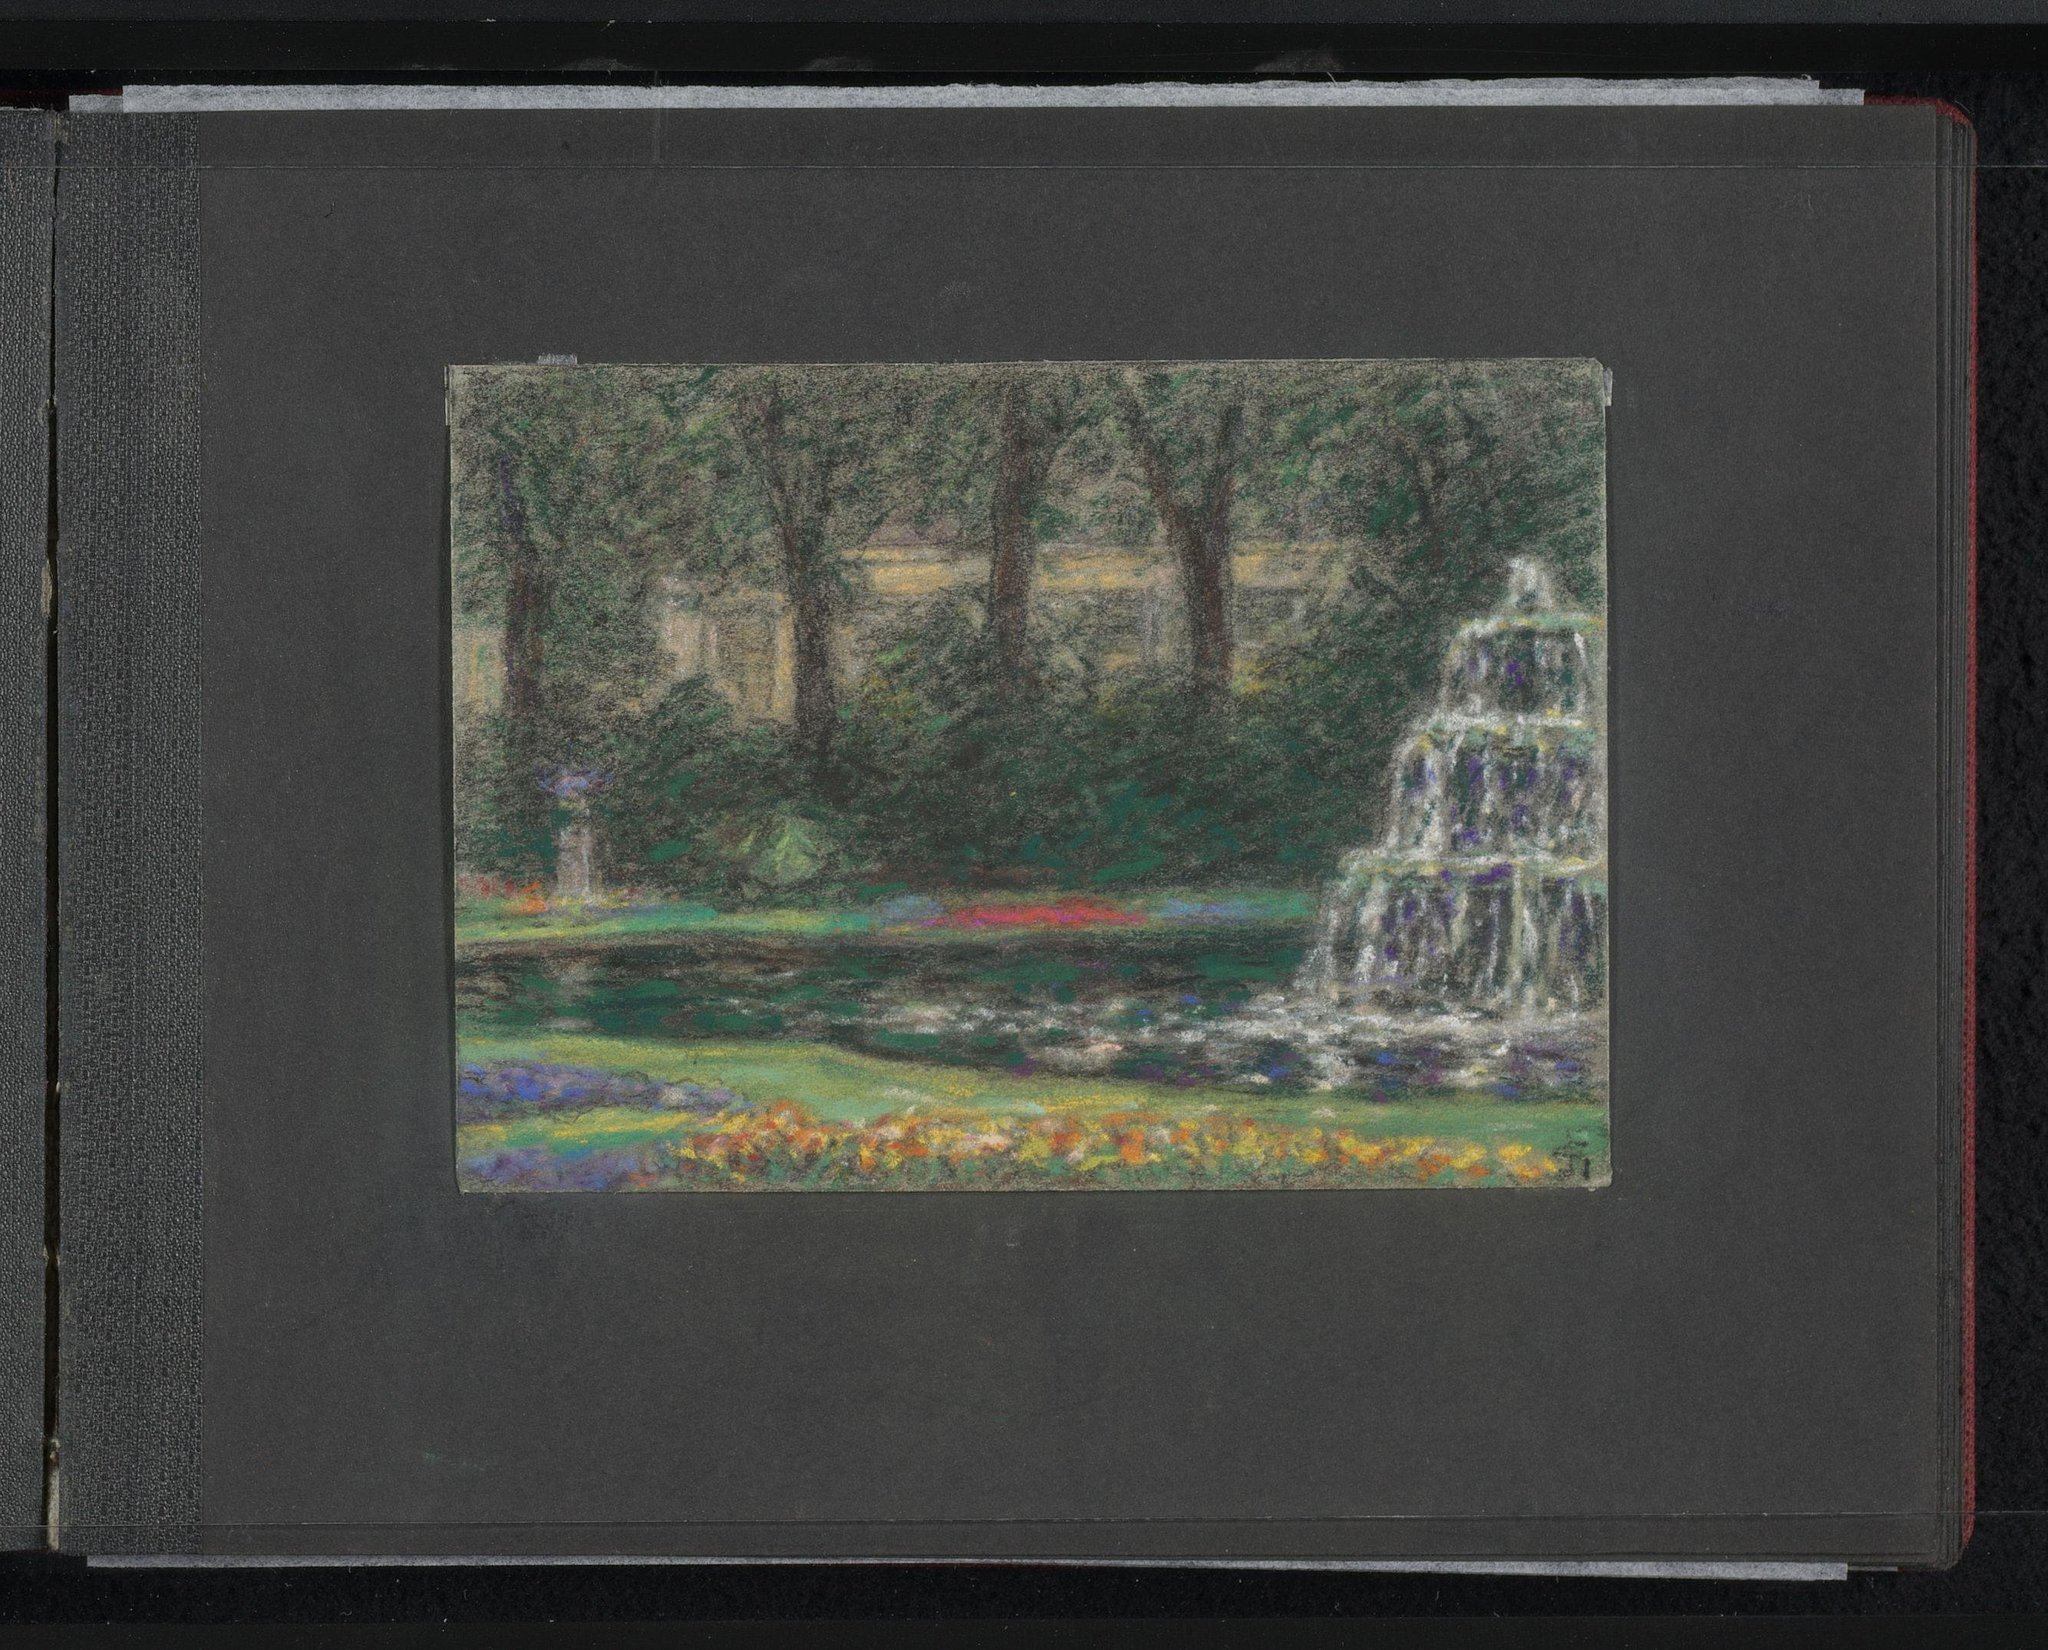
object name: album leaf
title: Park met vijver met fontein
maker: carel nicolaas storm van s-gravesande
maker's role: draughtsman, print maker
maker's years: 1841-1924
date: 1915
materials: chalk, paper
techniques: pasting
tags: garden fountain, garden pond, public gardens, park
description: Waarschijnlijk in het Kurpark te Wiesbaden. Tekening maakt deel uit van een album.